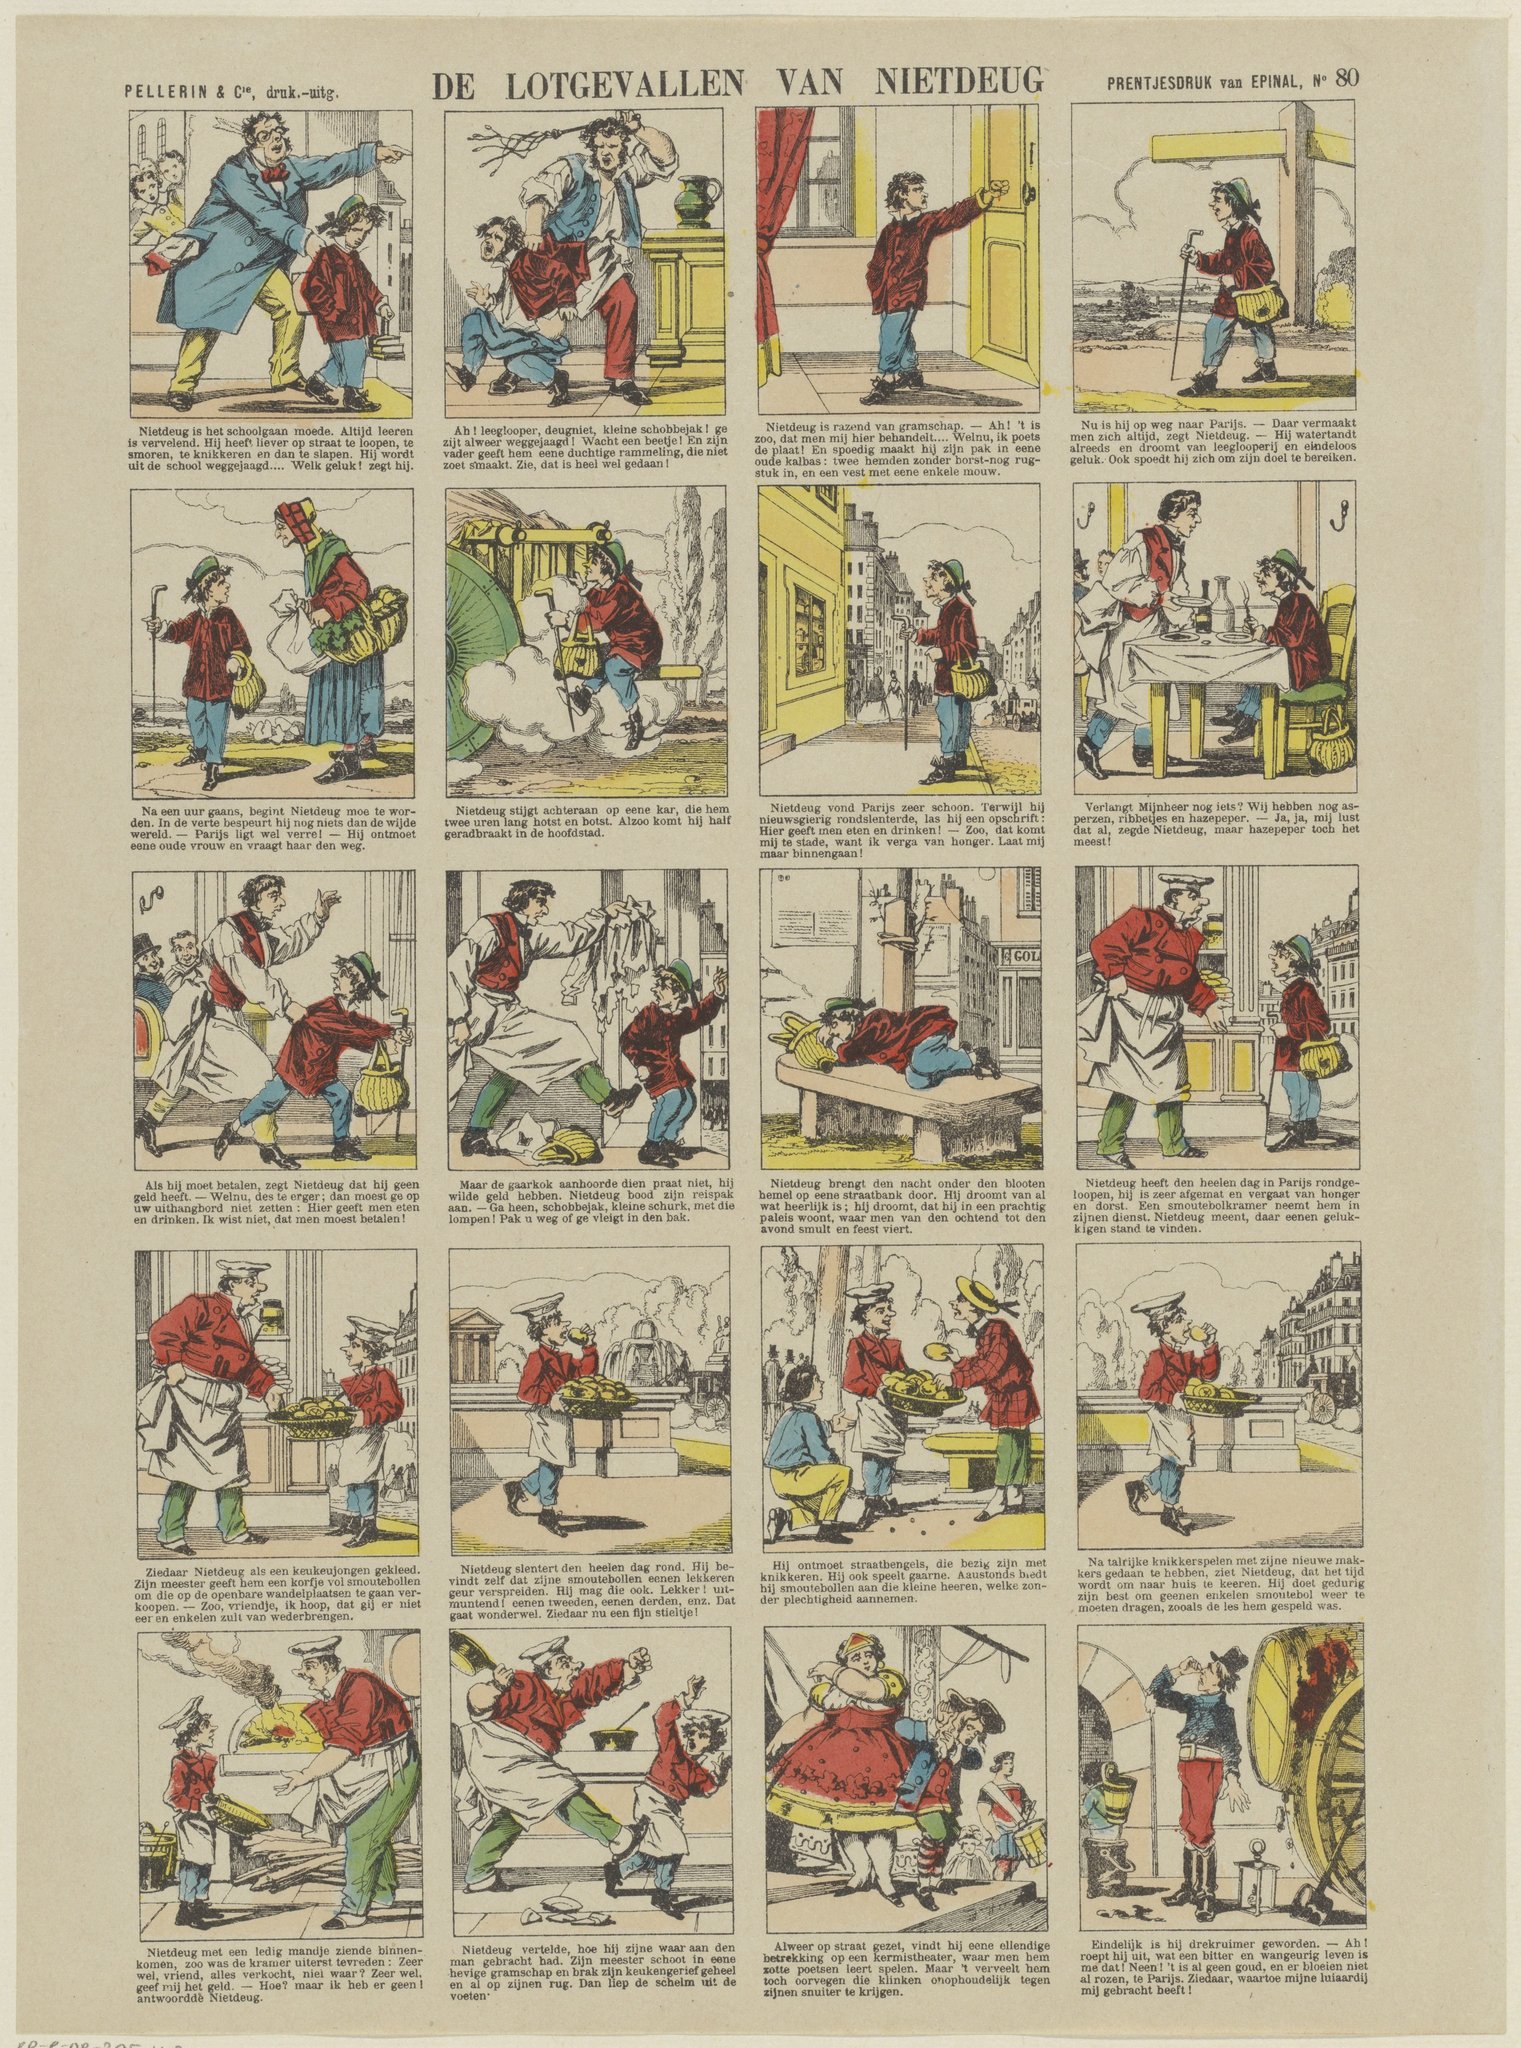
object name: print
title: De lotgevallen van Nietdeug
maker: Anonymous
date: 1902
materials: paper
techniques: colour, letterpress printing, lithograph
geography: epinal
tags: mischief-making play, bad behaviour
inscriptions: collector's mark: Lugt 2760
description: Blad met 16 voorstellingen over de streken van de deugniet genaamd Nietdeug. Onder elke afbeelding een onderschrift. Genummerd rechtsboven: No 80.